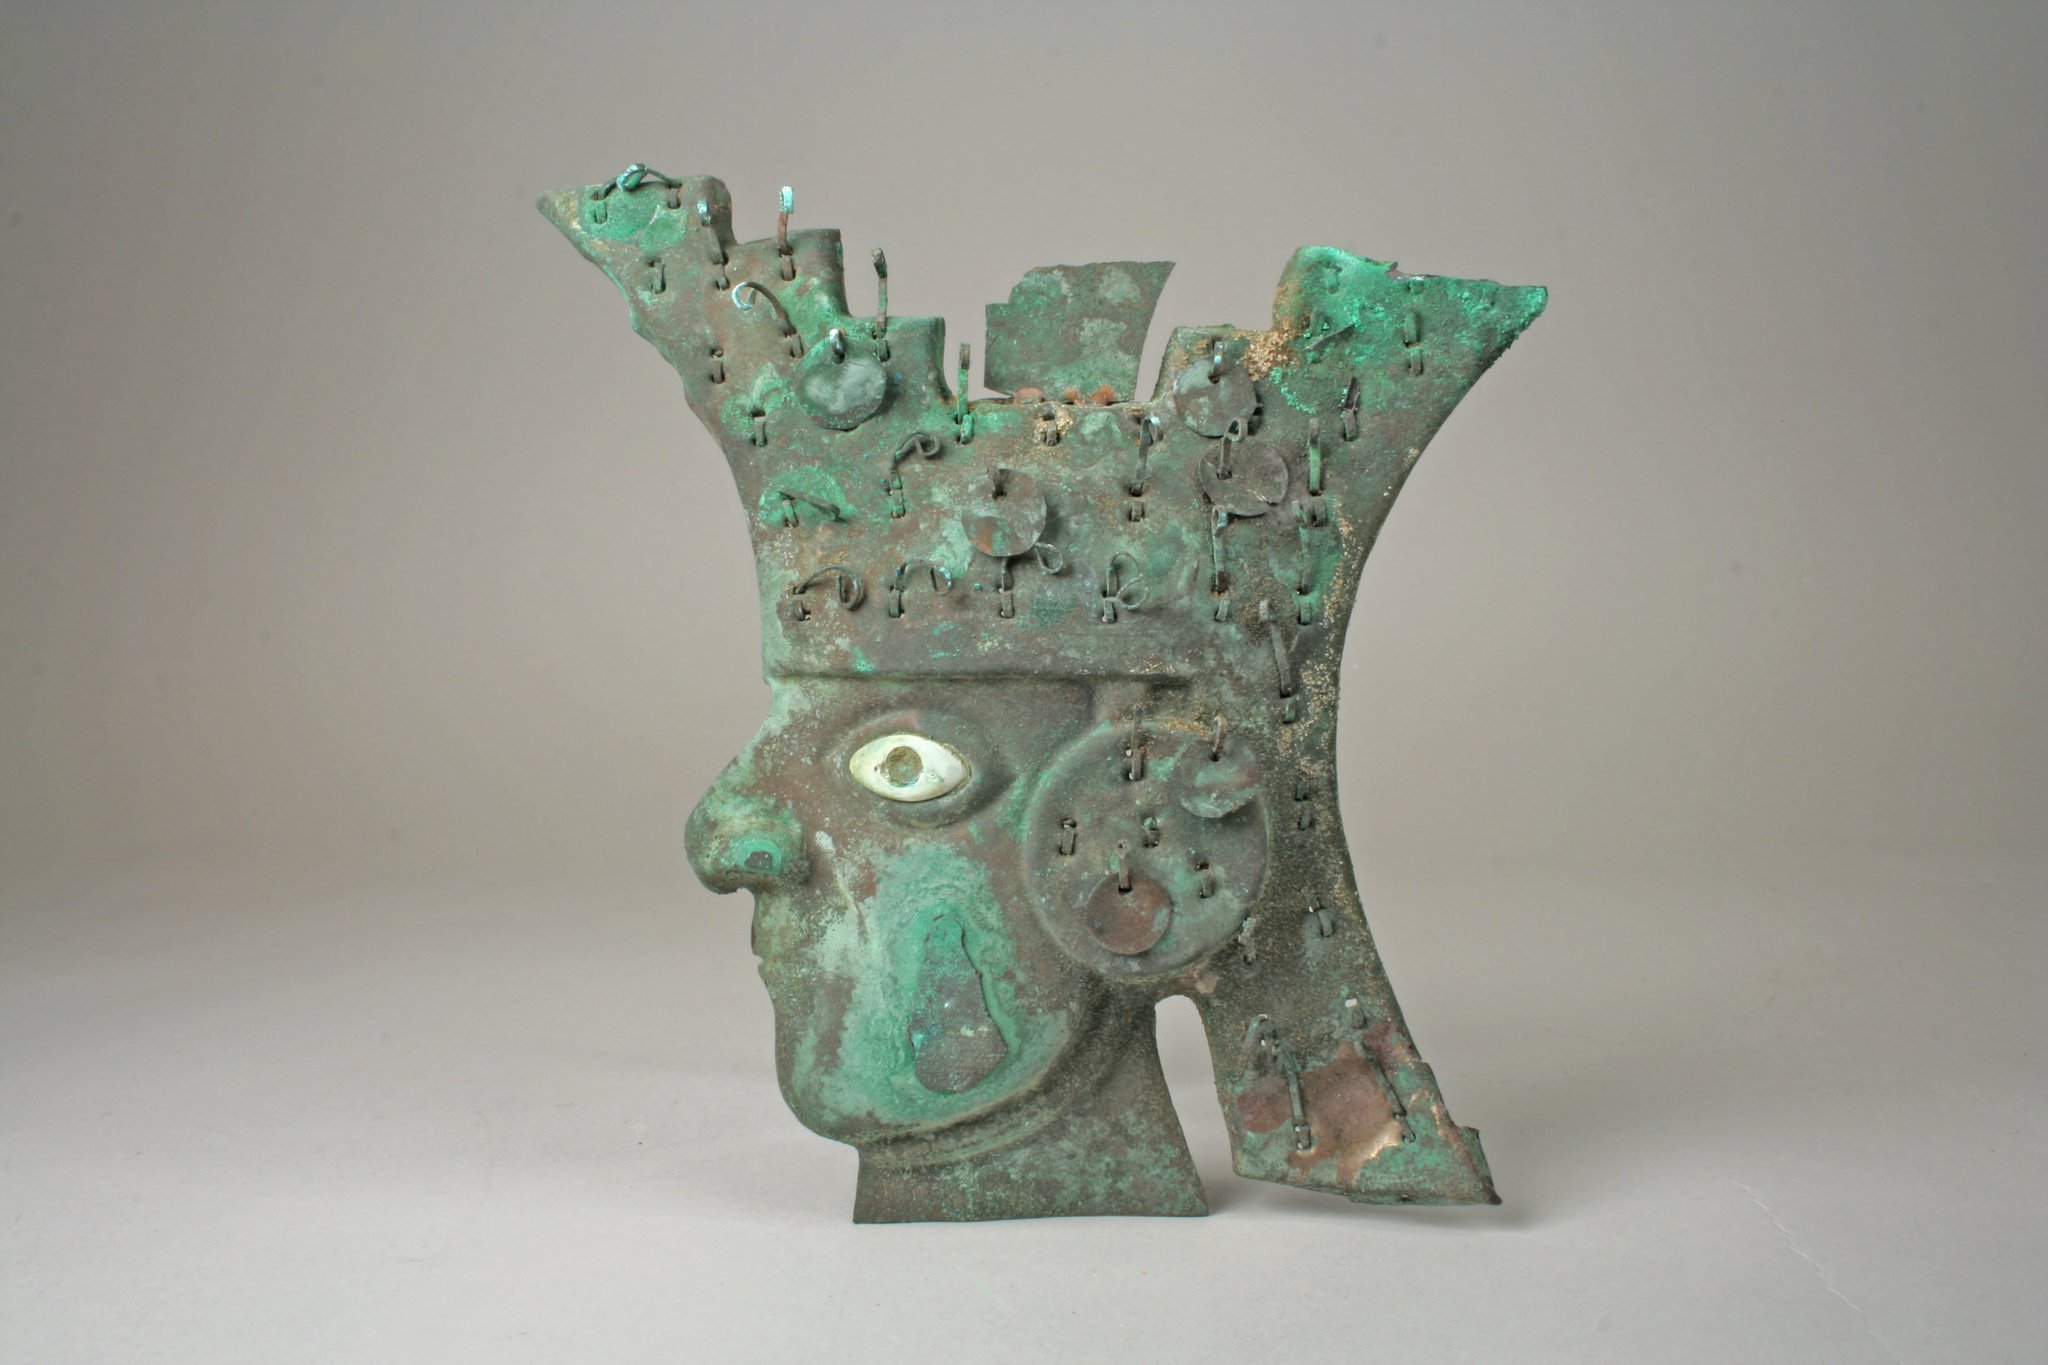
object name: ornament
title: Profile Face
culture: moche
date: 501-700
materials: shell, metal, stone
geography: peru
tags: faces,profiles